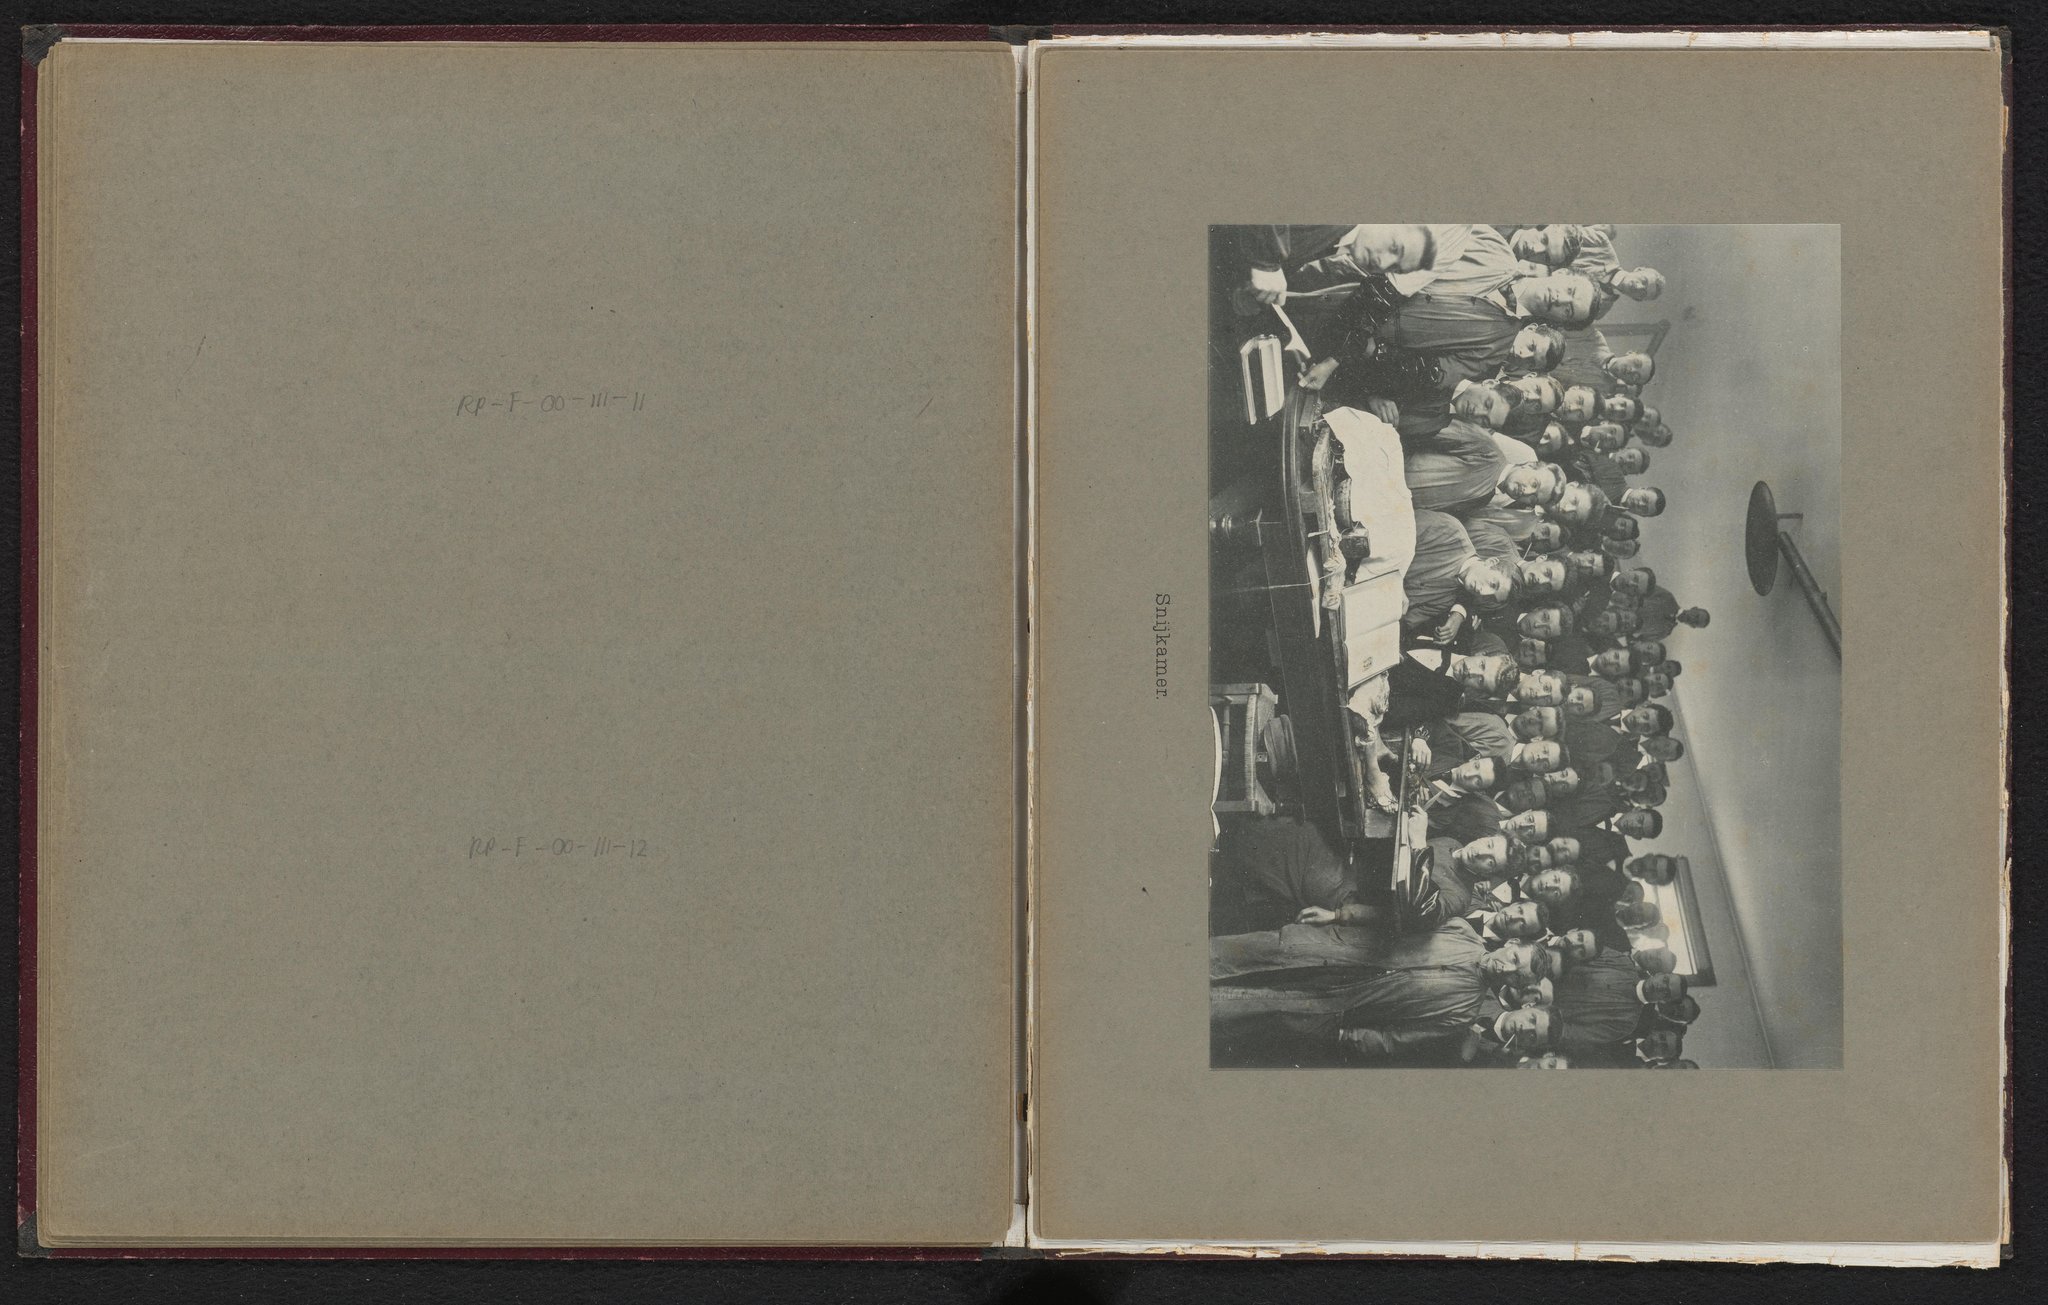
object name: photomechanical print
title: Snijkamer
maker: Anonymous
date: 1902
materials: cardboard, paper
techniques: photograph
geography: amsterdam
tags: university building, college, dissecting-room, 'theatrum anatomicum'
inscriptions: stamp: ‘HISTORISCHE COMMISSIE DER UNIVERSITEIT VAN AMSTERDAM’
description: Deze prent maakt deel uit van een omslag met vijftien lichtdrukken op twaalf kartonnen bladen.